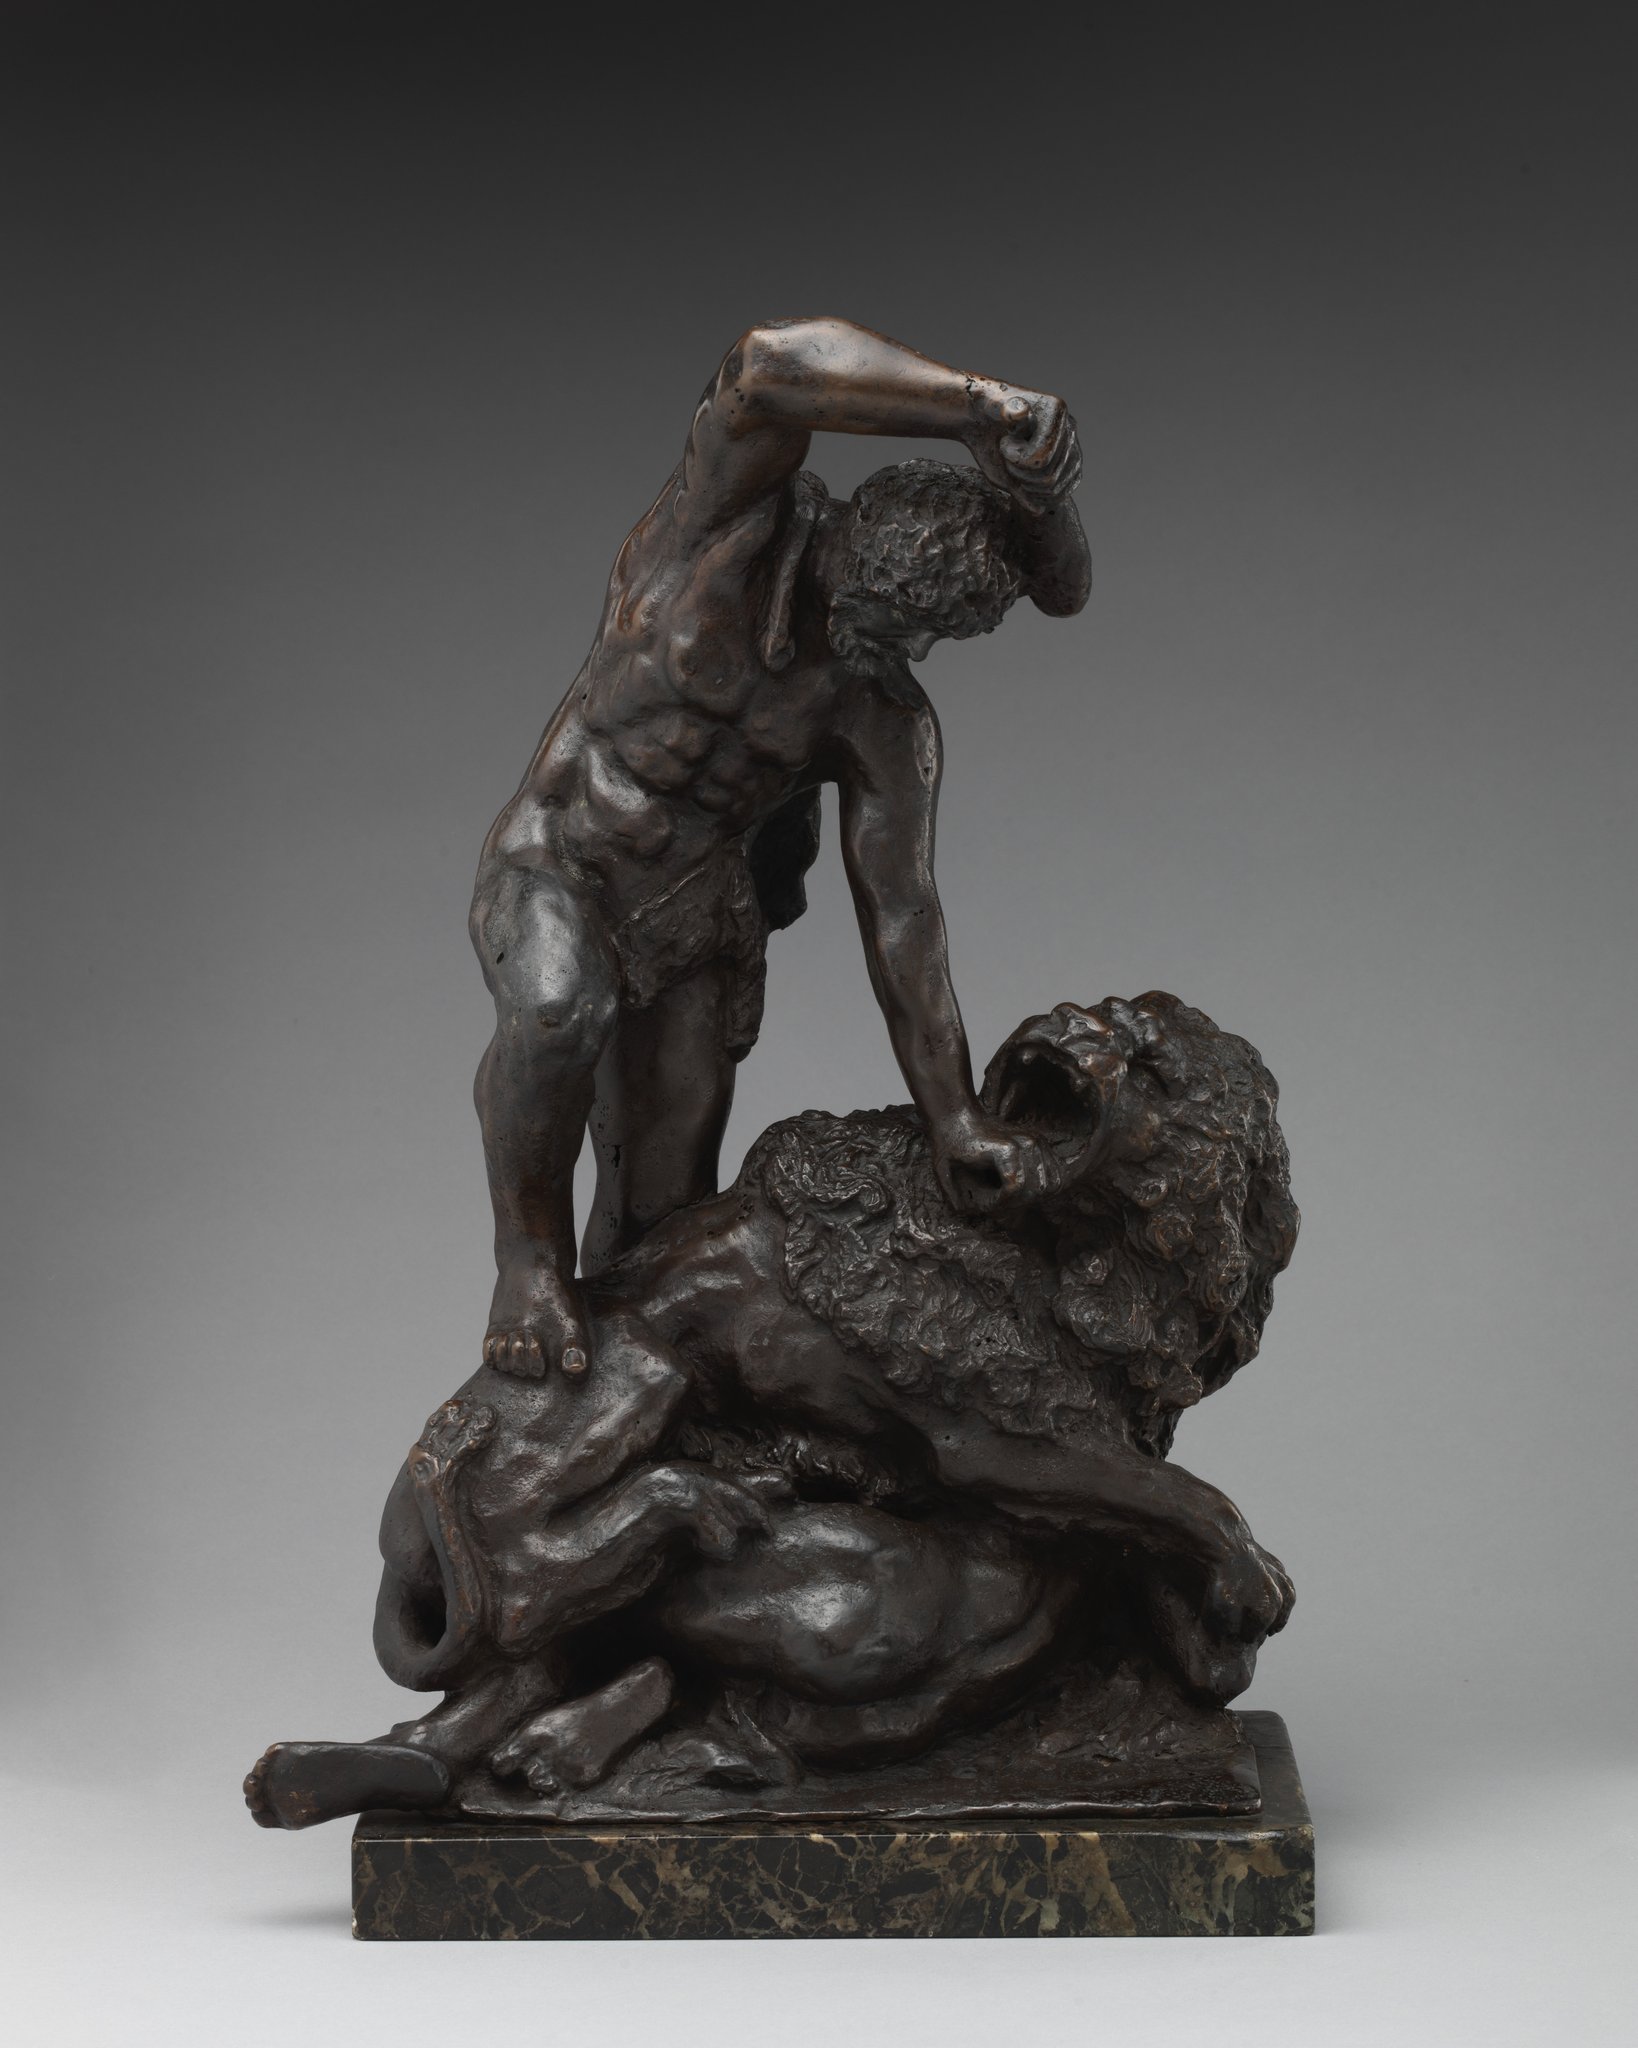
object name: statuette group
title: Two Men Fighting a Lion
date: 1601-1800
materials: bronze, lacquer, patina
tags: men,lions